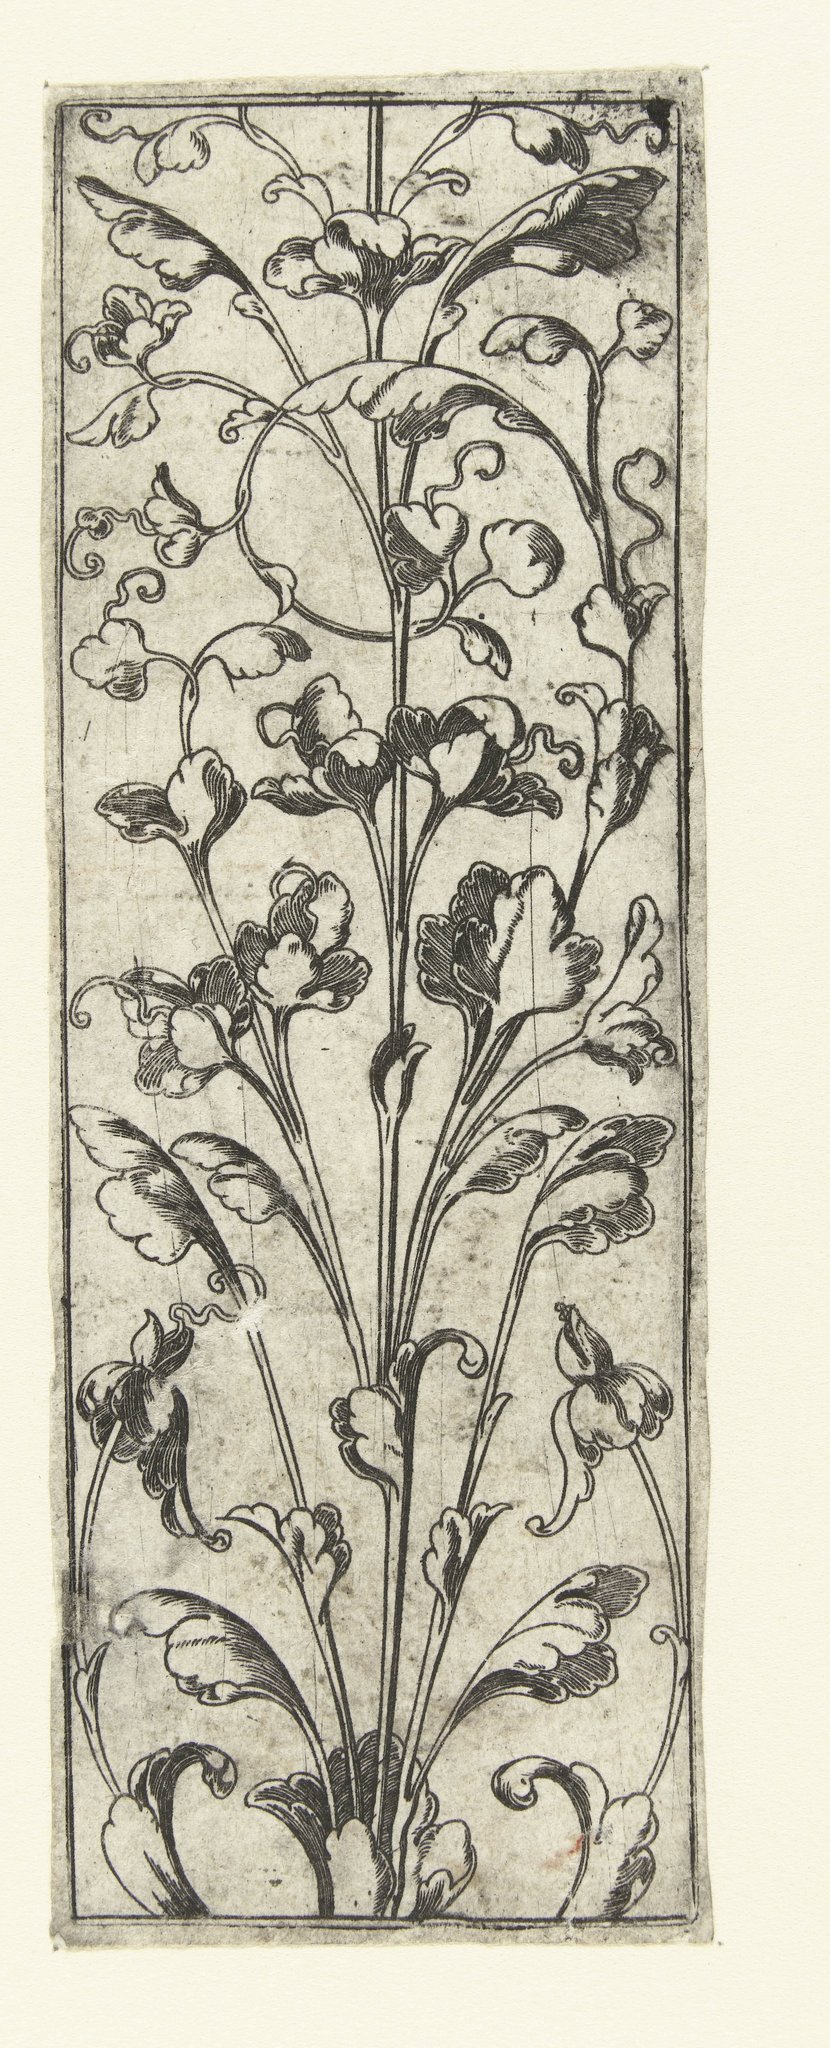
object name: print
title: Rechte stengel tussen kleinere stengels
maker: Anonymous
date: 1500-1600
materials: paper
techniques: engraving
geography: germany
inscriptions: collector's mark: Lugt 240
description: Vlakdecoratie met een stengel, die middenonder samen met kleinere stengels uit een blad ontspruit en die kaarsrecht naar boven steekt. Op circa tweederde van de vlakdecoratie vormt een van de zijscheuten een voluut naar links. Tegenzijdige kopie van prent met objectnummer RP-P-OB-8163.